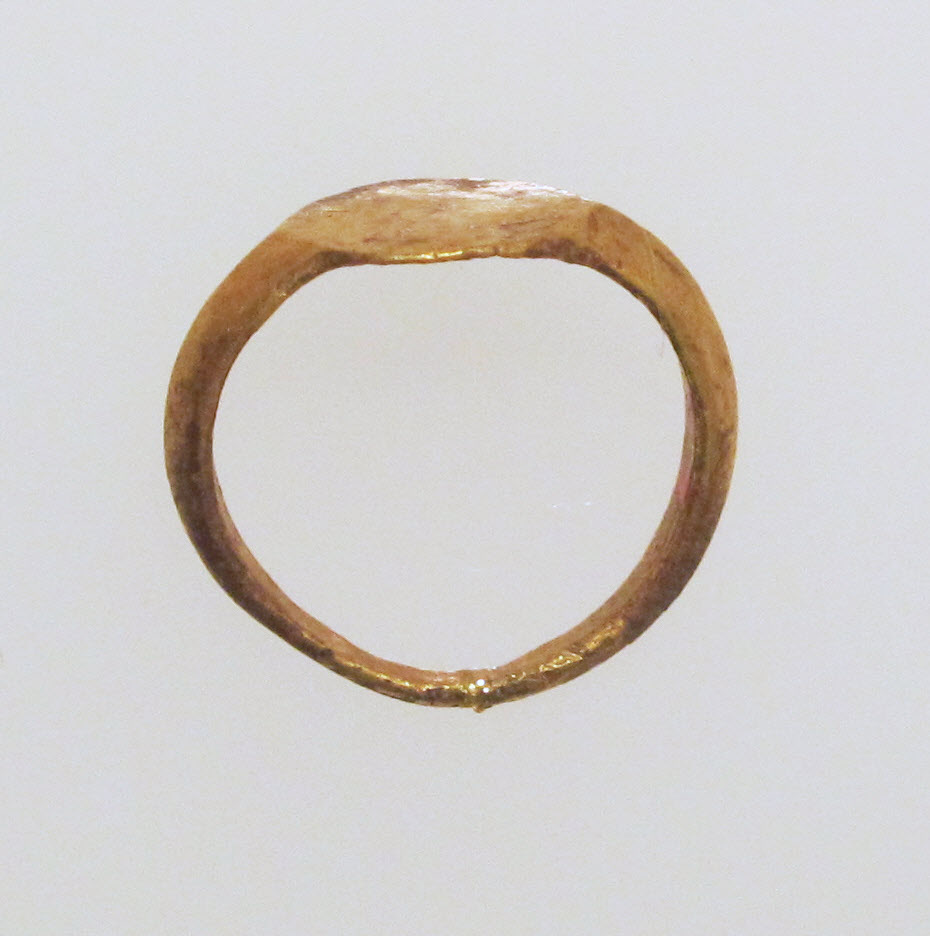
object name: ring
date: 7000 BCE-330 CE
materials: gold